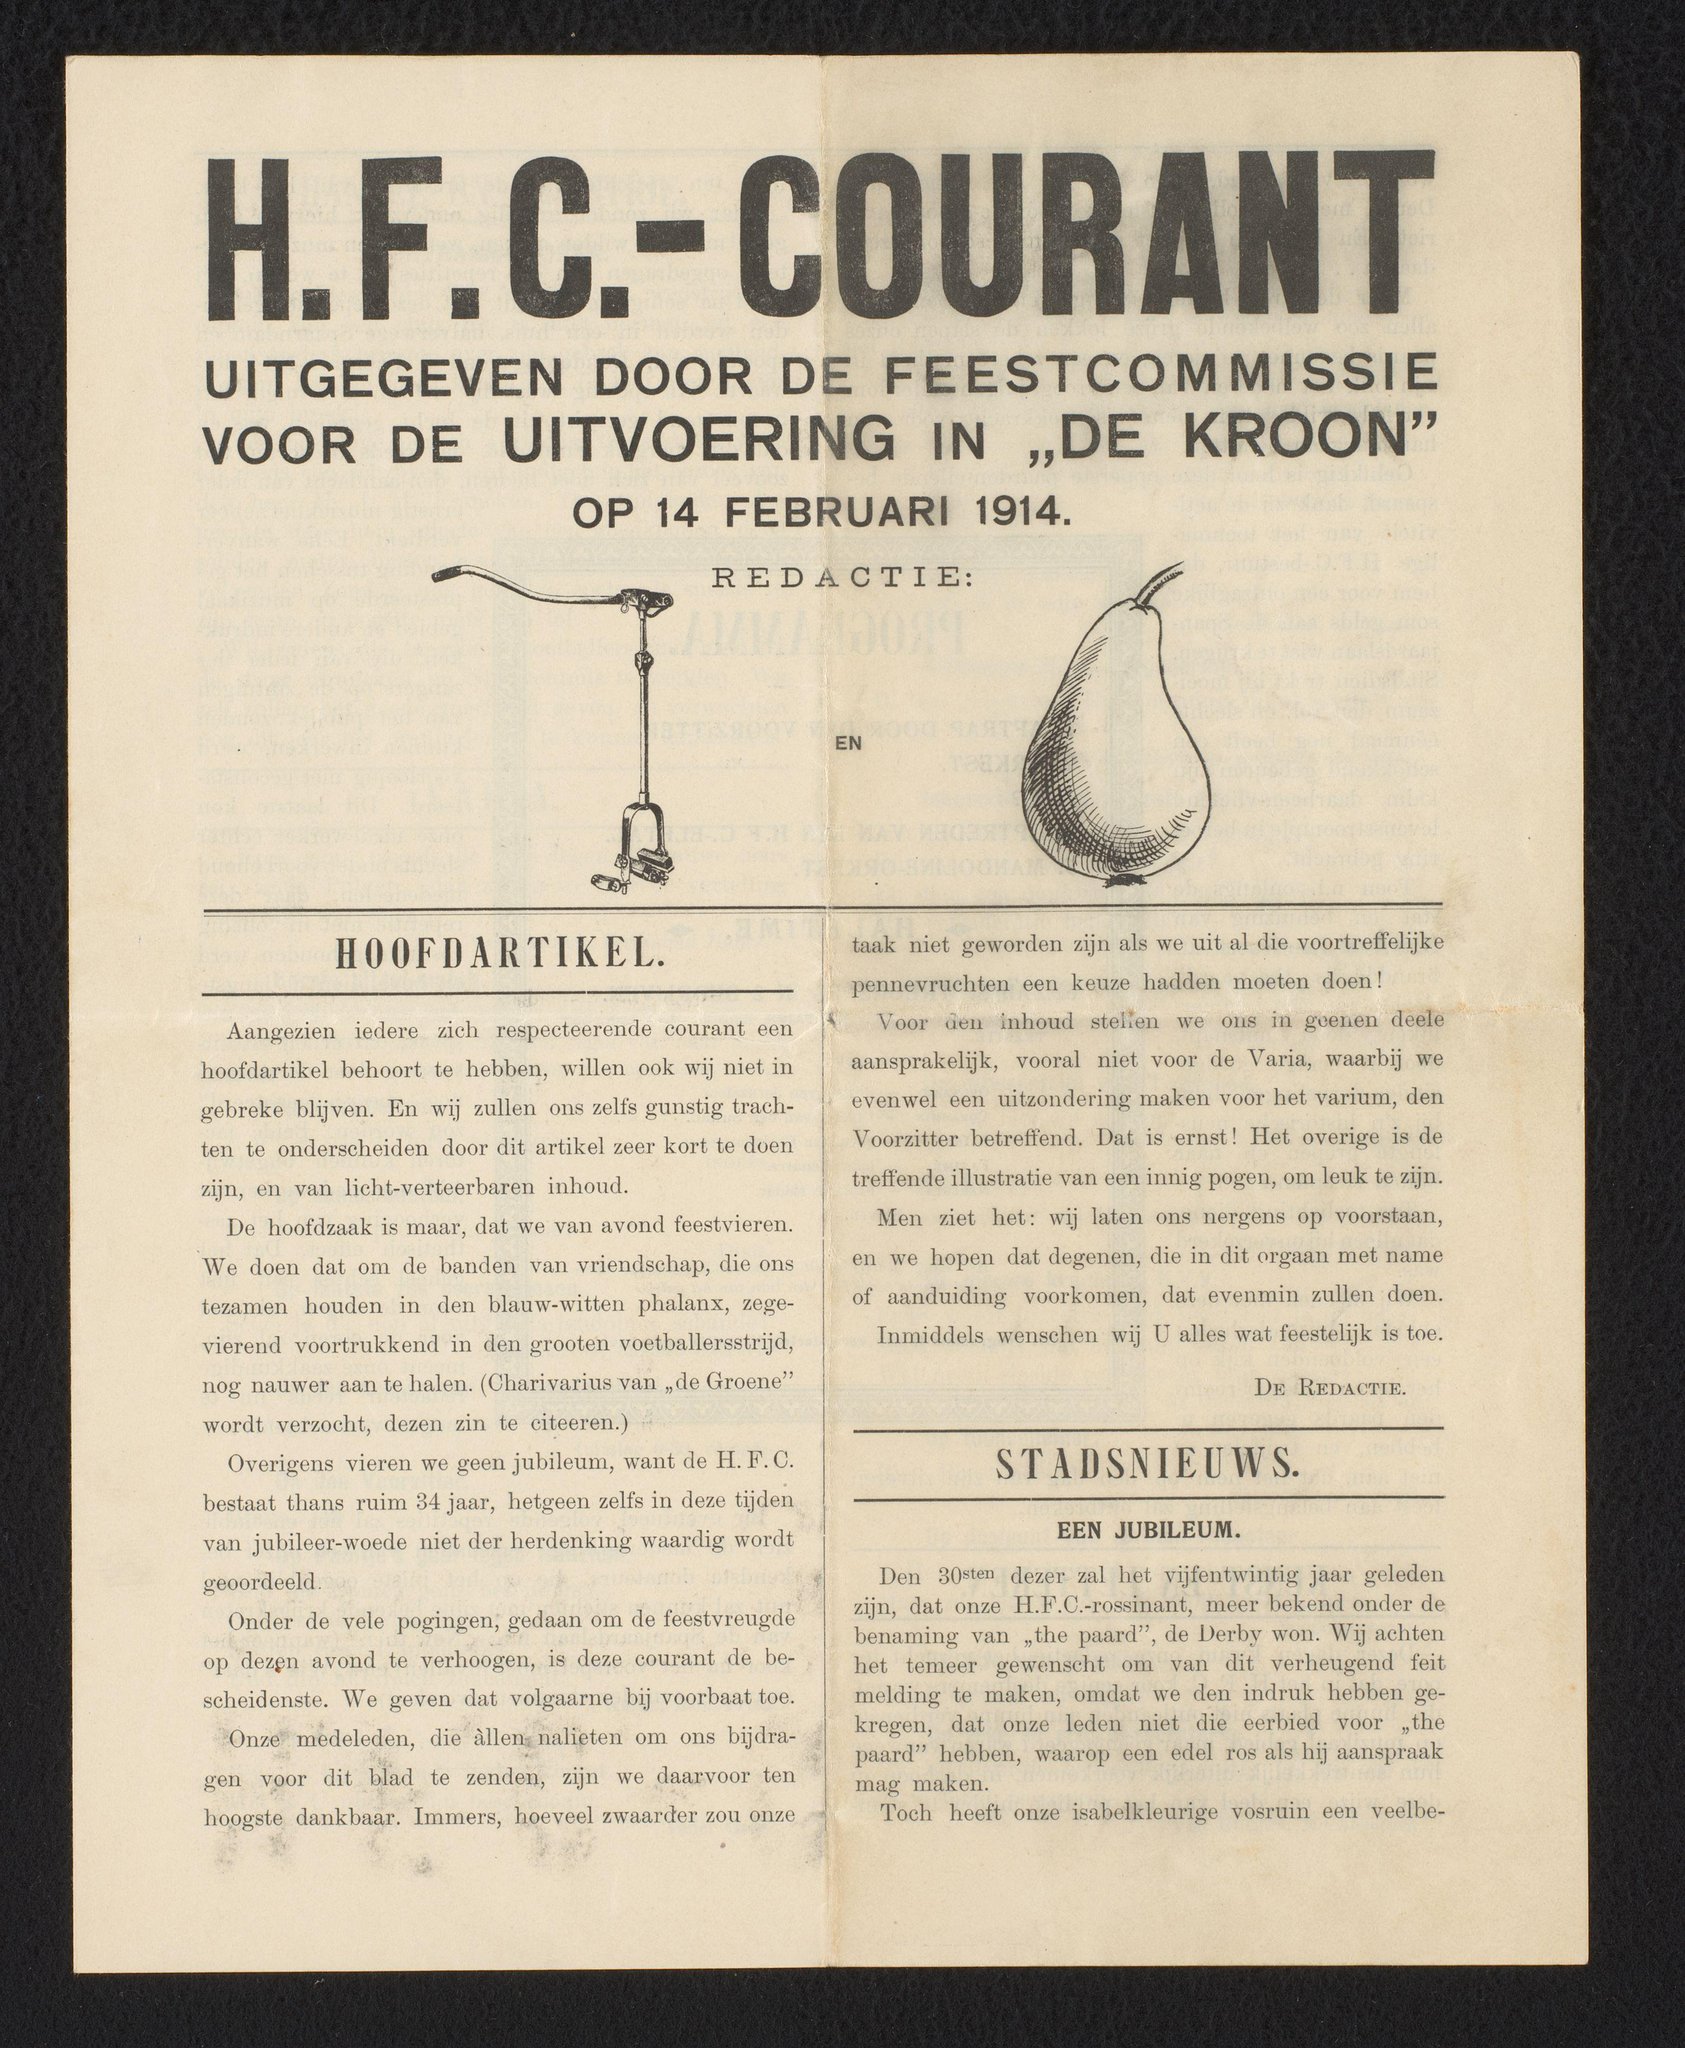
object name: photomechanical print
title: Programma voor de feestavond op 14 februari 1914 van H.F.C.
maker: Anonymous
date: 1914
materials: paper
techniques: printing block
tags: fruits: pear, haarlem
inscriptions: date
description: Gevouwen blad met op de voorzijde een peer en een mechanisch object (als rebus voor de namen van de redactie). H.F.C. is de Koninklijke Haarlemsche Football Club. Humoristische artikelen over het wel een wee van de club en het programma van de avond, met onder andere een uitvoeren van 'Zaïre' ('Zeer vrij bewerkt naar Voltaire'). De avond zou gehouden worden in De Kroon op 14 februari 1914.